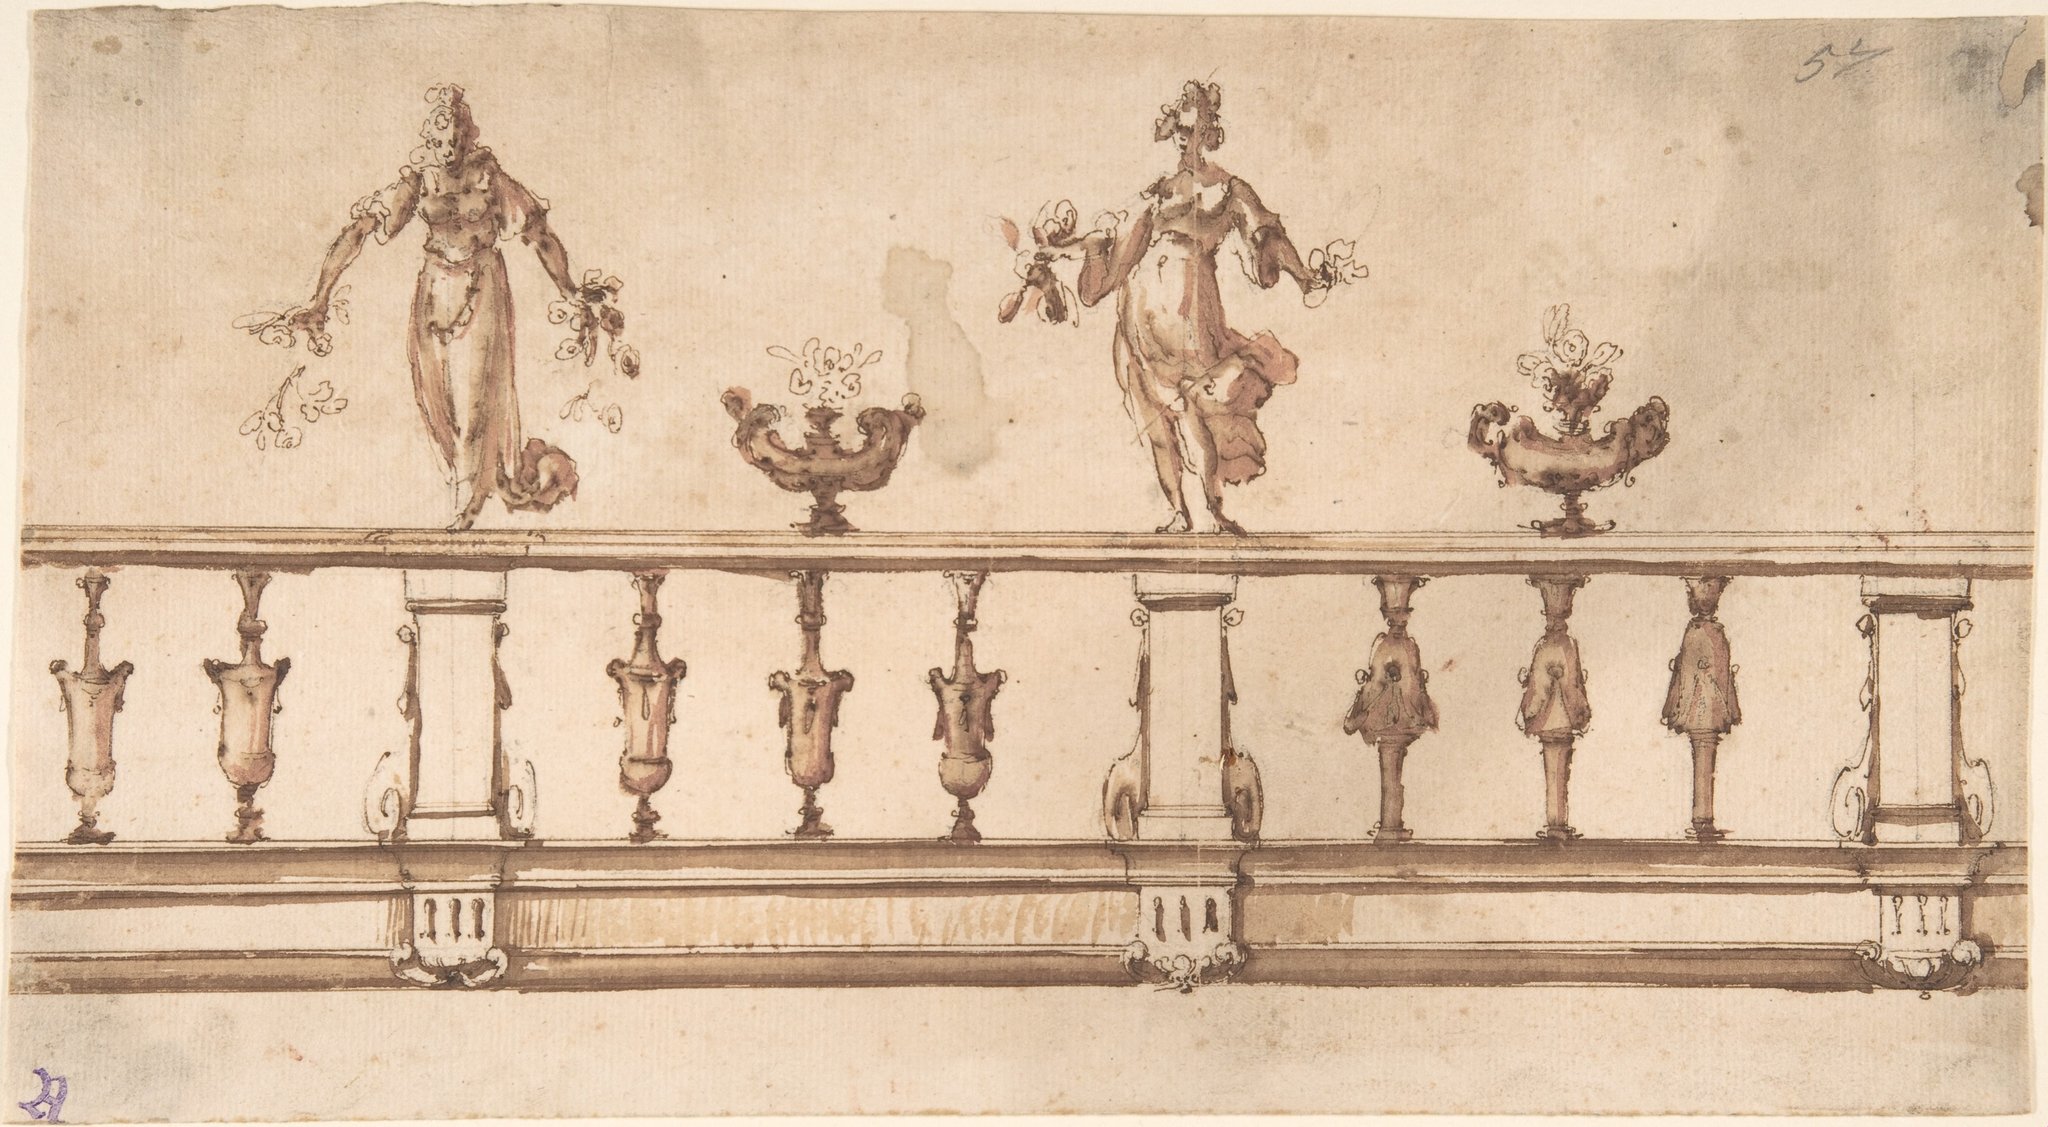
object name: drawing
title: Design for a Balustrade with Female Figures and Urns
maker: giulio parigi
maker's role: artist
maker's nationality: italian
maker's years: 1571-1635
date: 1501-1700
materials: graphite, ink, watercolor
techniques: brush, pen, wash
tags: architecture,women,urns